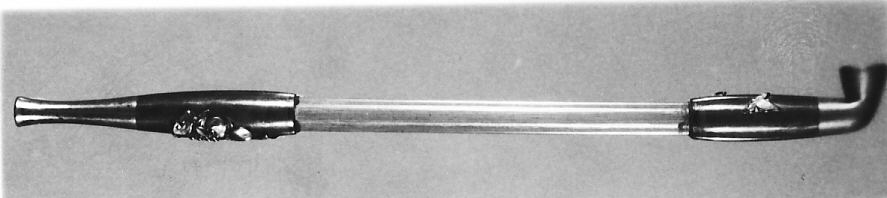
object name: tobacco pipe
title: Woman's Tobacco-Pipe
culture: japanese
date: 1801-1900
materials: metal, silk, wood